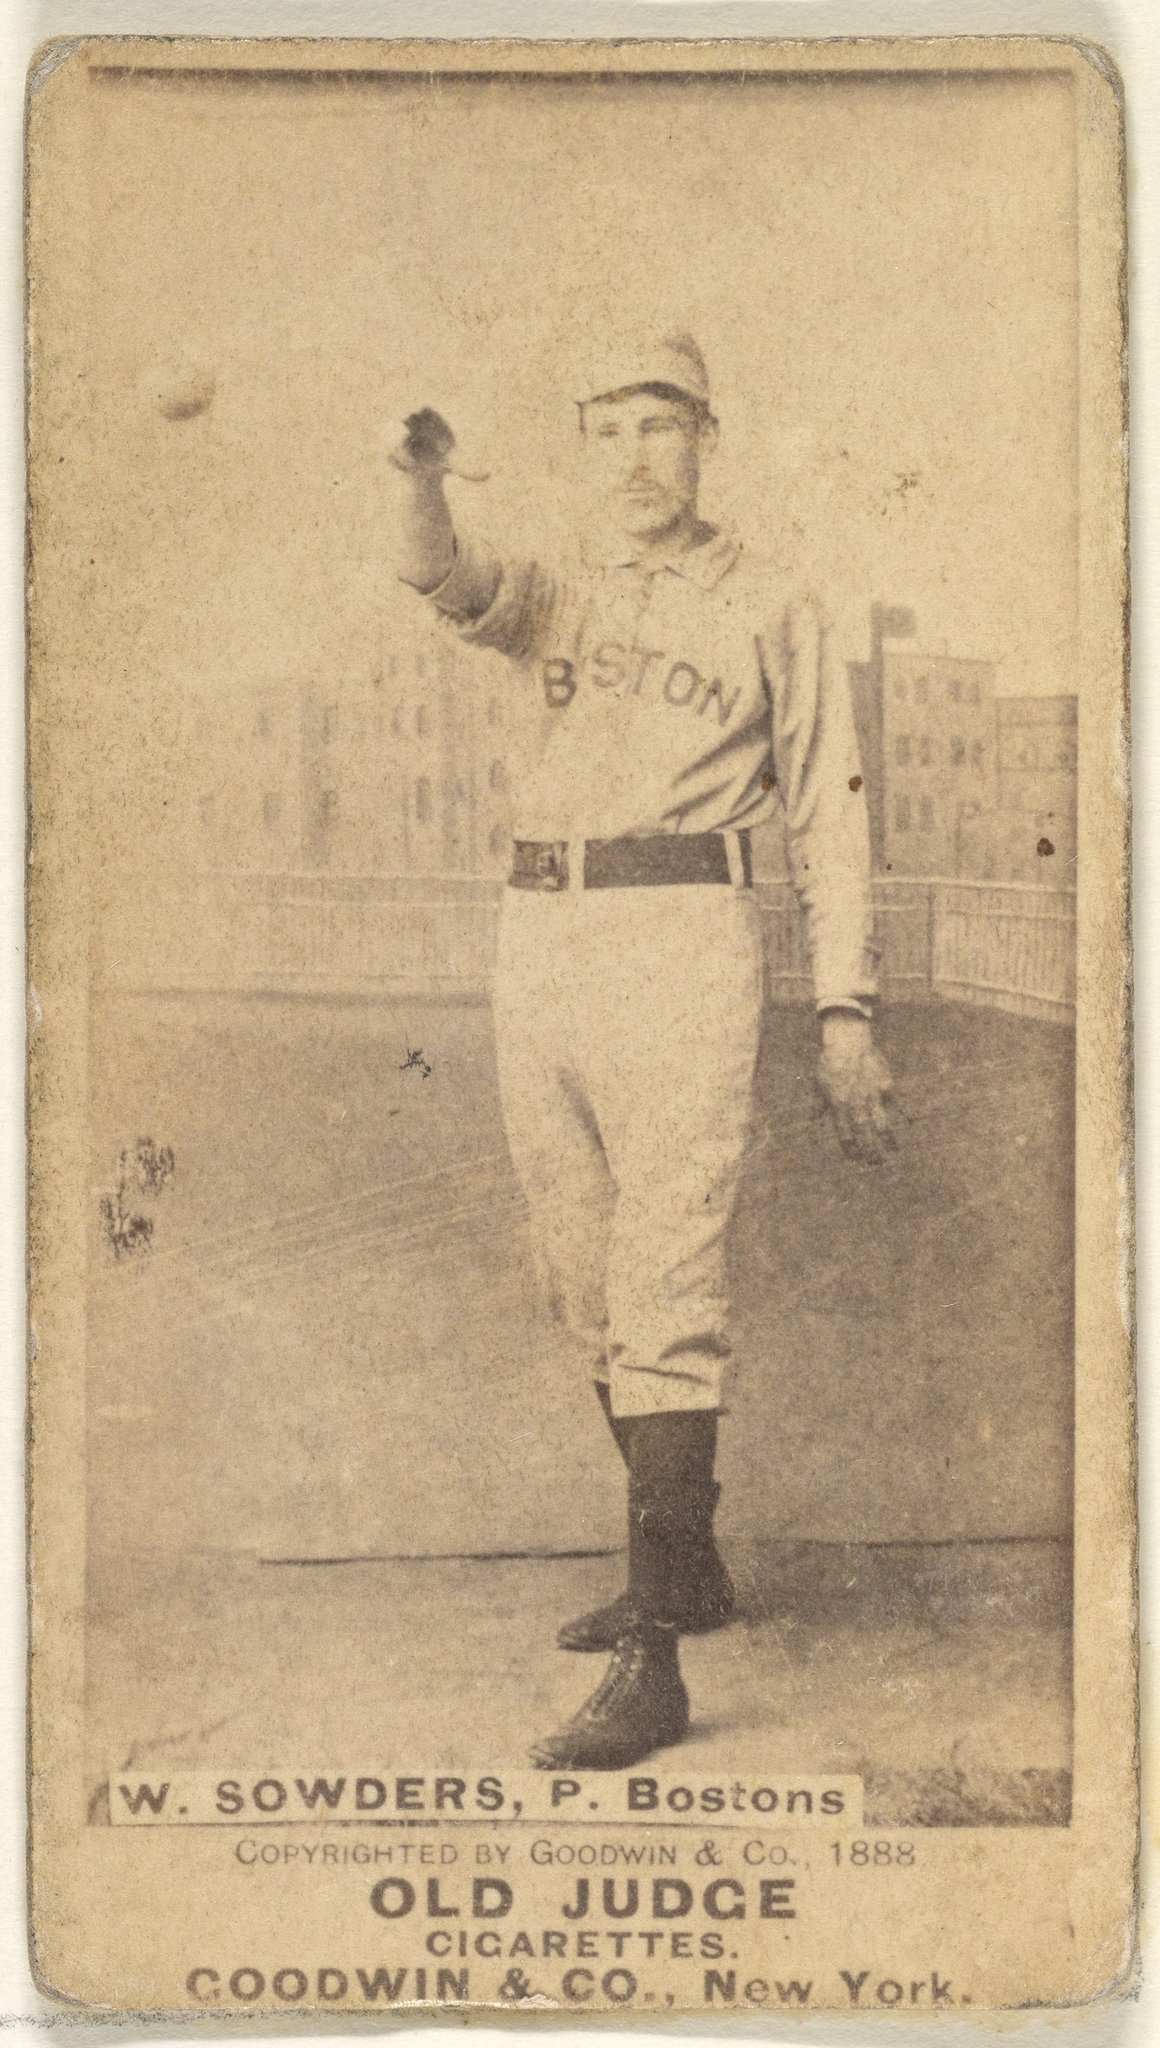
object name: baseball card, photograph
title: W. Sowders, Pitcher, Boston, from the Old Judge series (N172) for Old Judge Cigarettes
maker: goodwin & company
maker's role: publisher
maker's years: 1850-1950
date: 1888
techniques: albumen silver print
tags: men,portraits,baseball,athletes